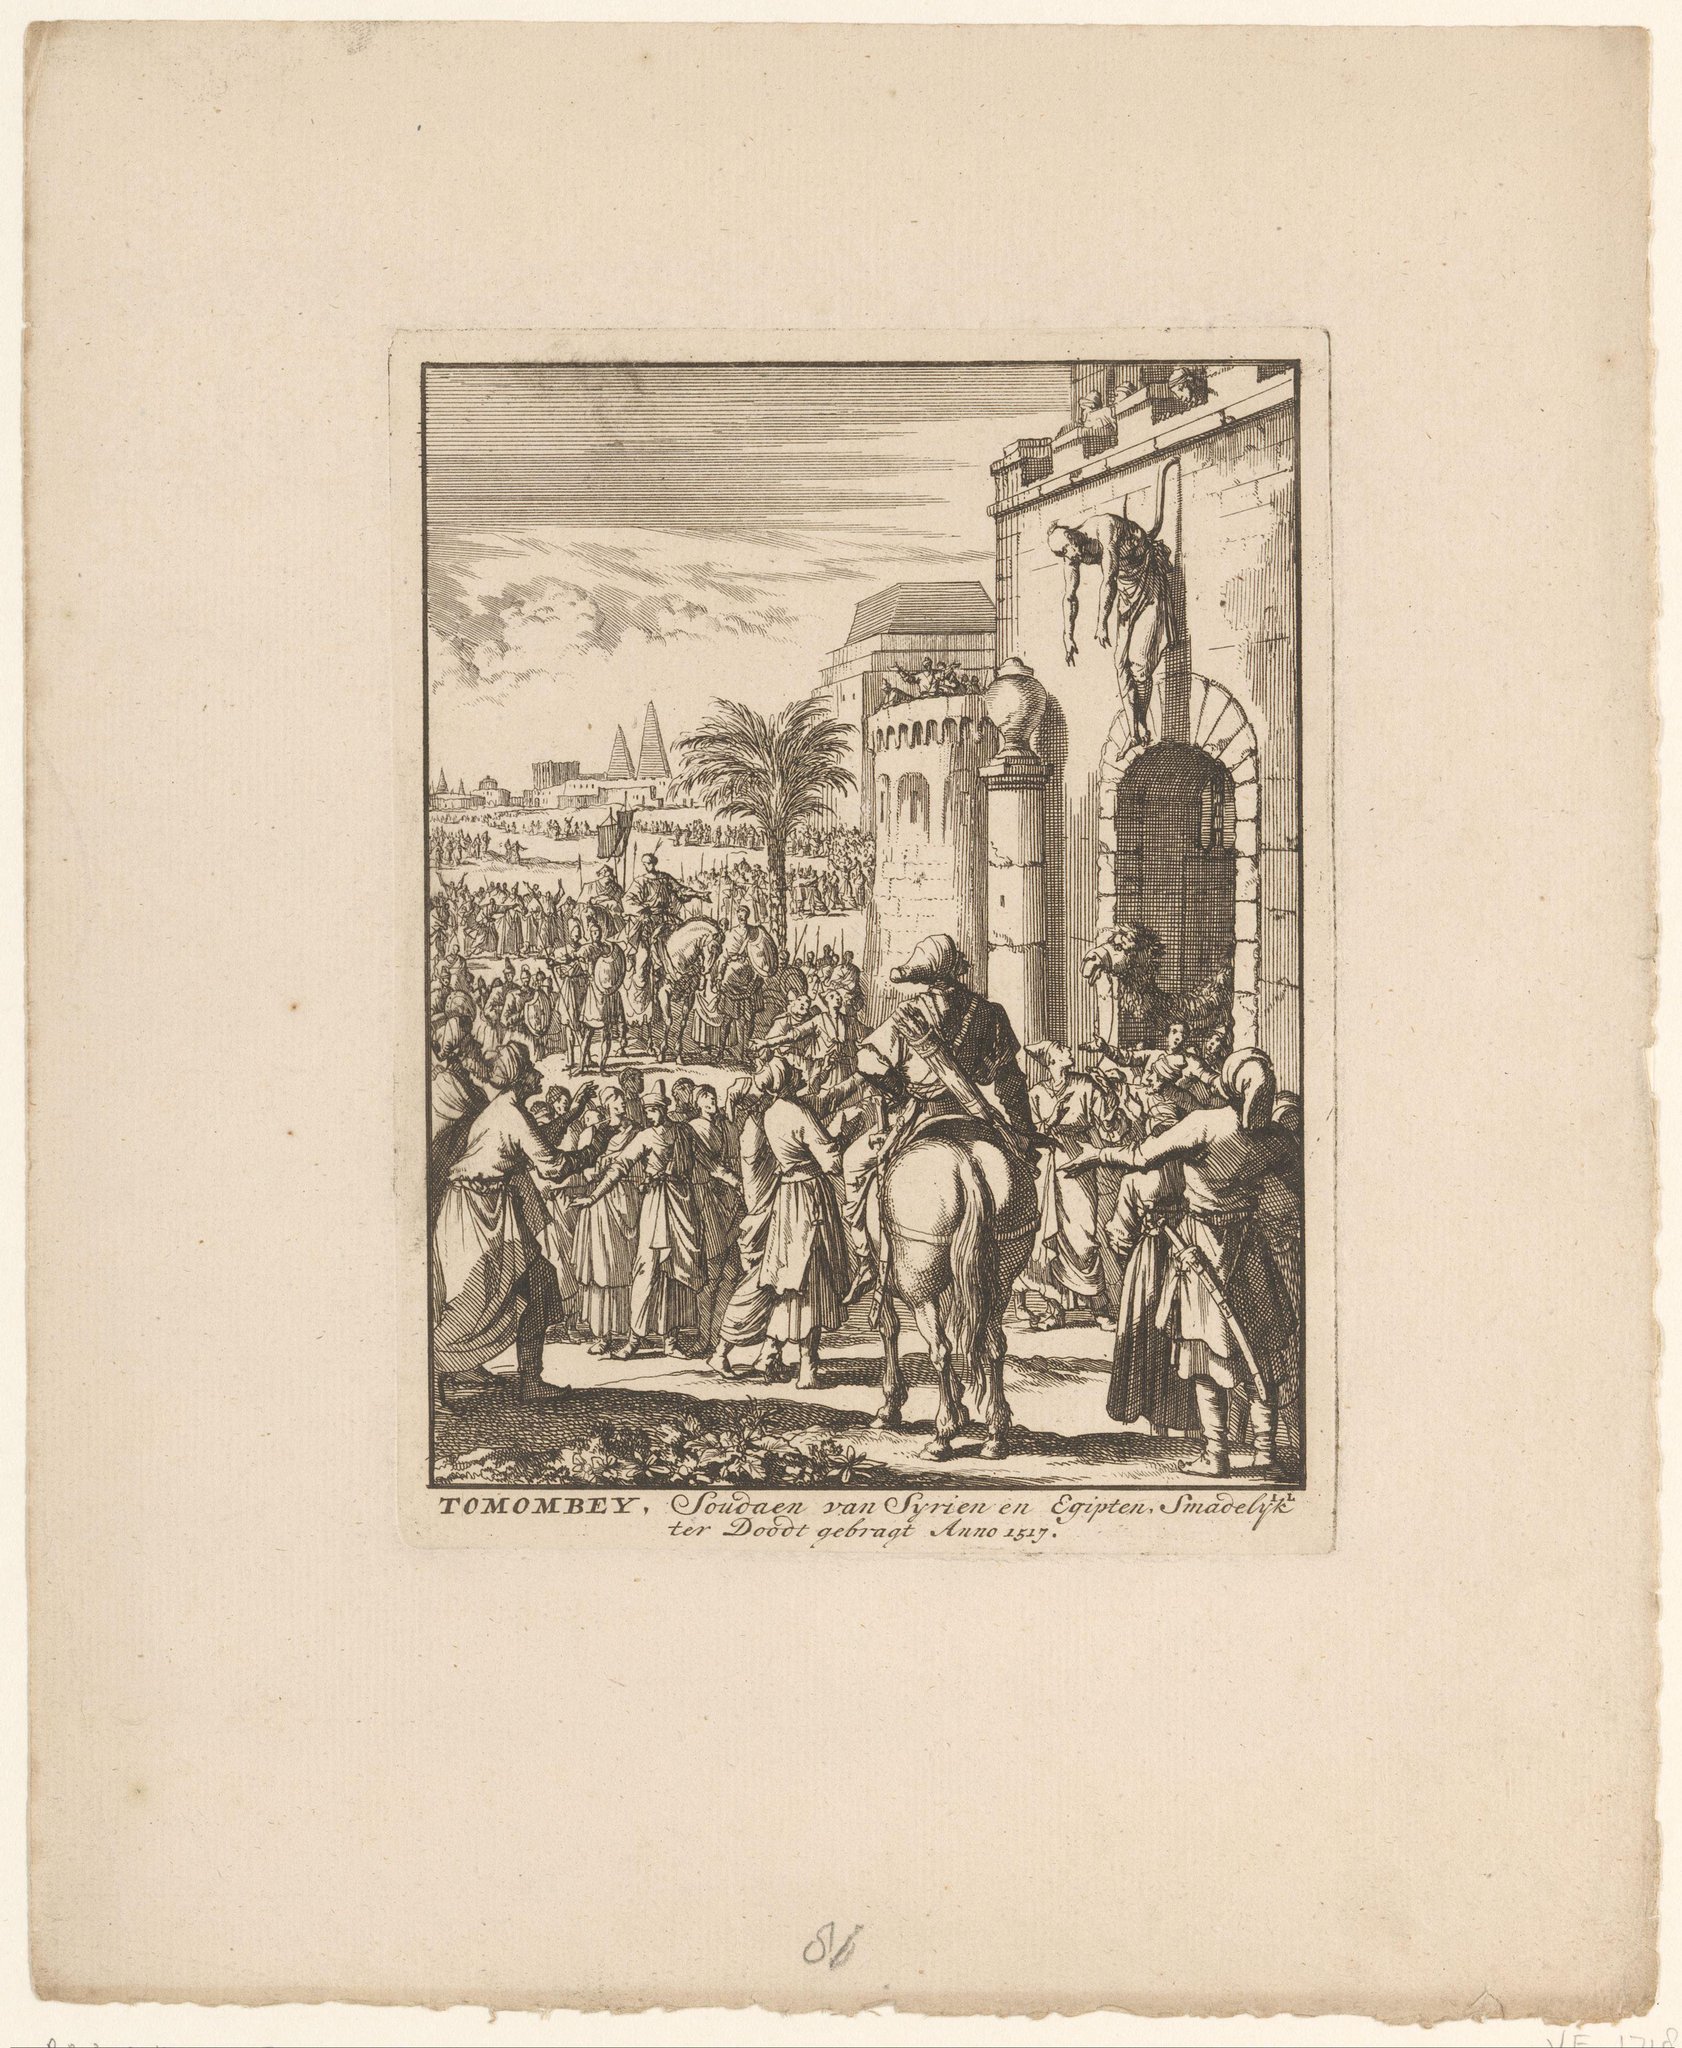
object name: print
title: Tomombey, Soudaen van Syrien en Egipten, Smadelyk ter Doodt gebragt Anno 1517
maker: jan luyken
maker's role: draughtsman, print maker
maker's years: 1649-1712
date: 1698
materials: paper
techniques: etching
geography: netherlands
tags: violent death by hanging, city-gate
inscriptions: collector's mark: Lugt 2228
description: Proefdruk van illustratie uit: Bos, Lambert van den. Treur-toonneel der doorluchtige mannen, of Op- en ondergang der grooten, 3 delen. Amsterdam: Jan Claesz ten Hoorn, 1698, dl. II.